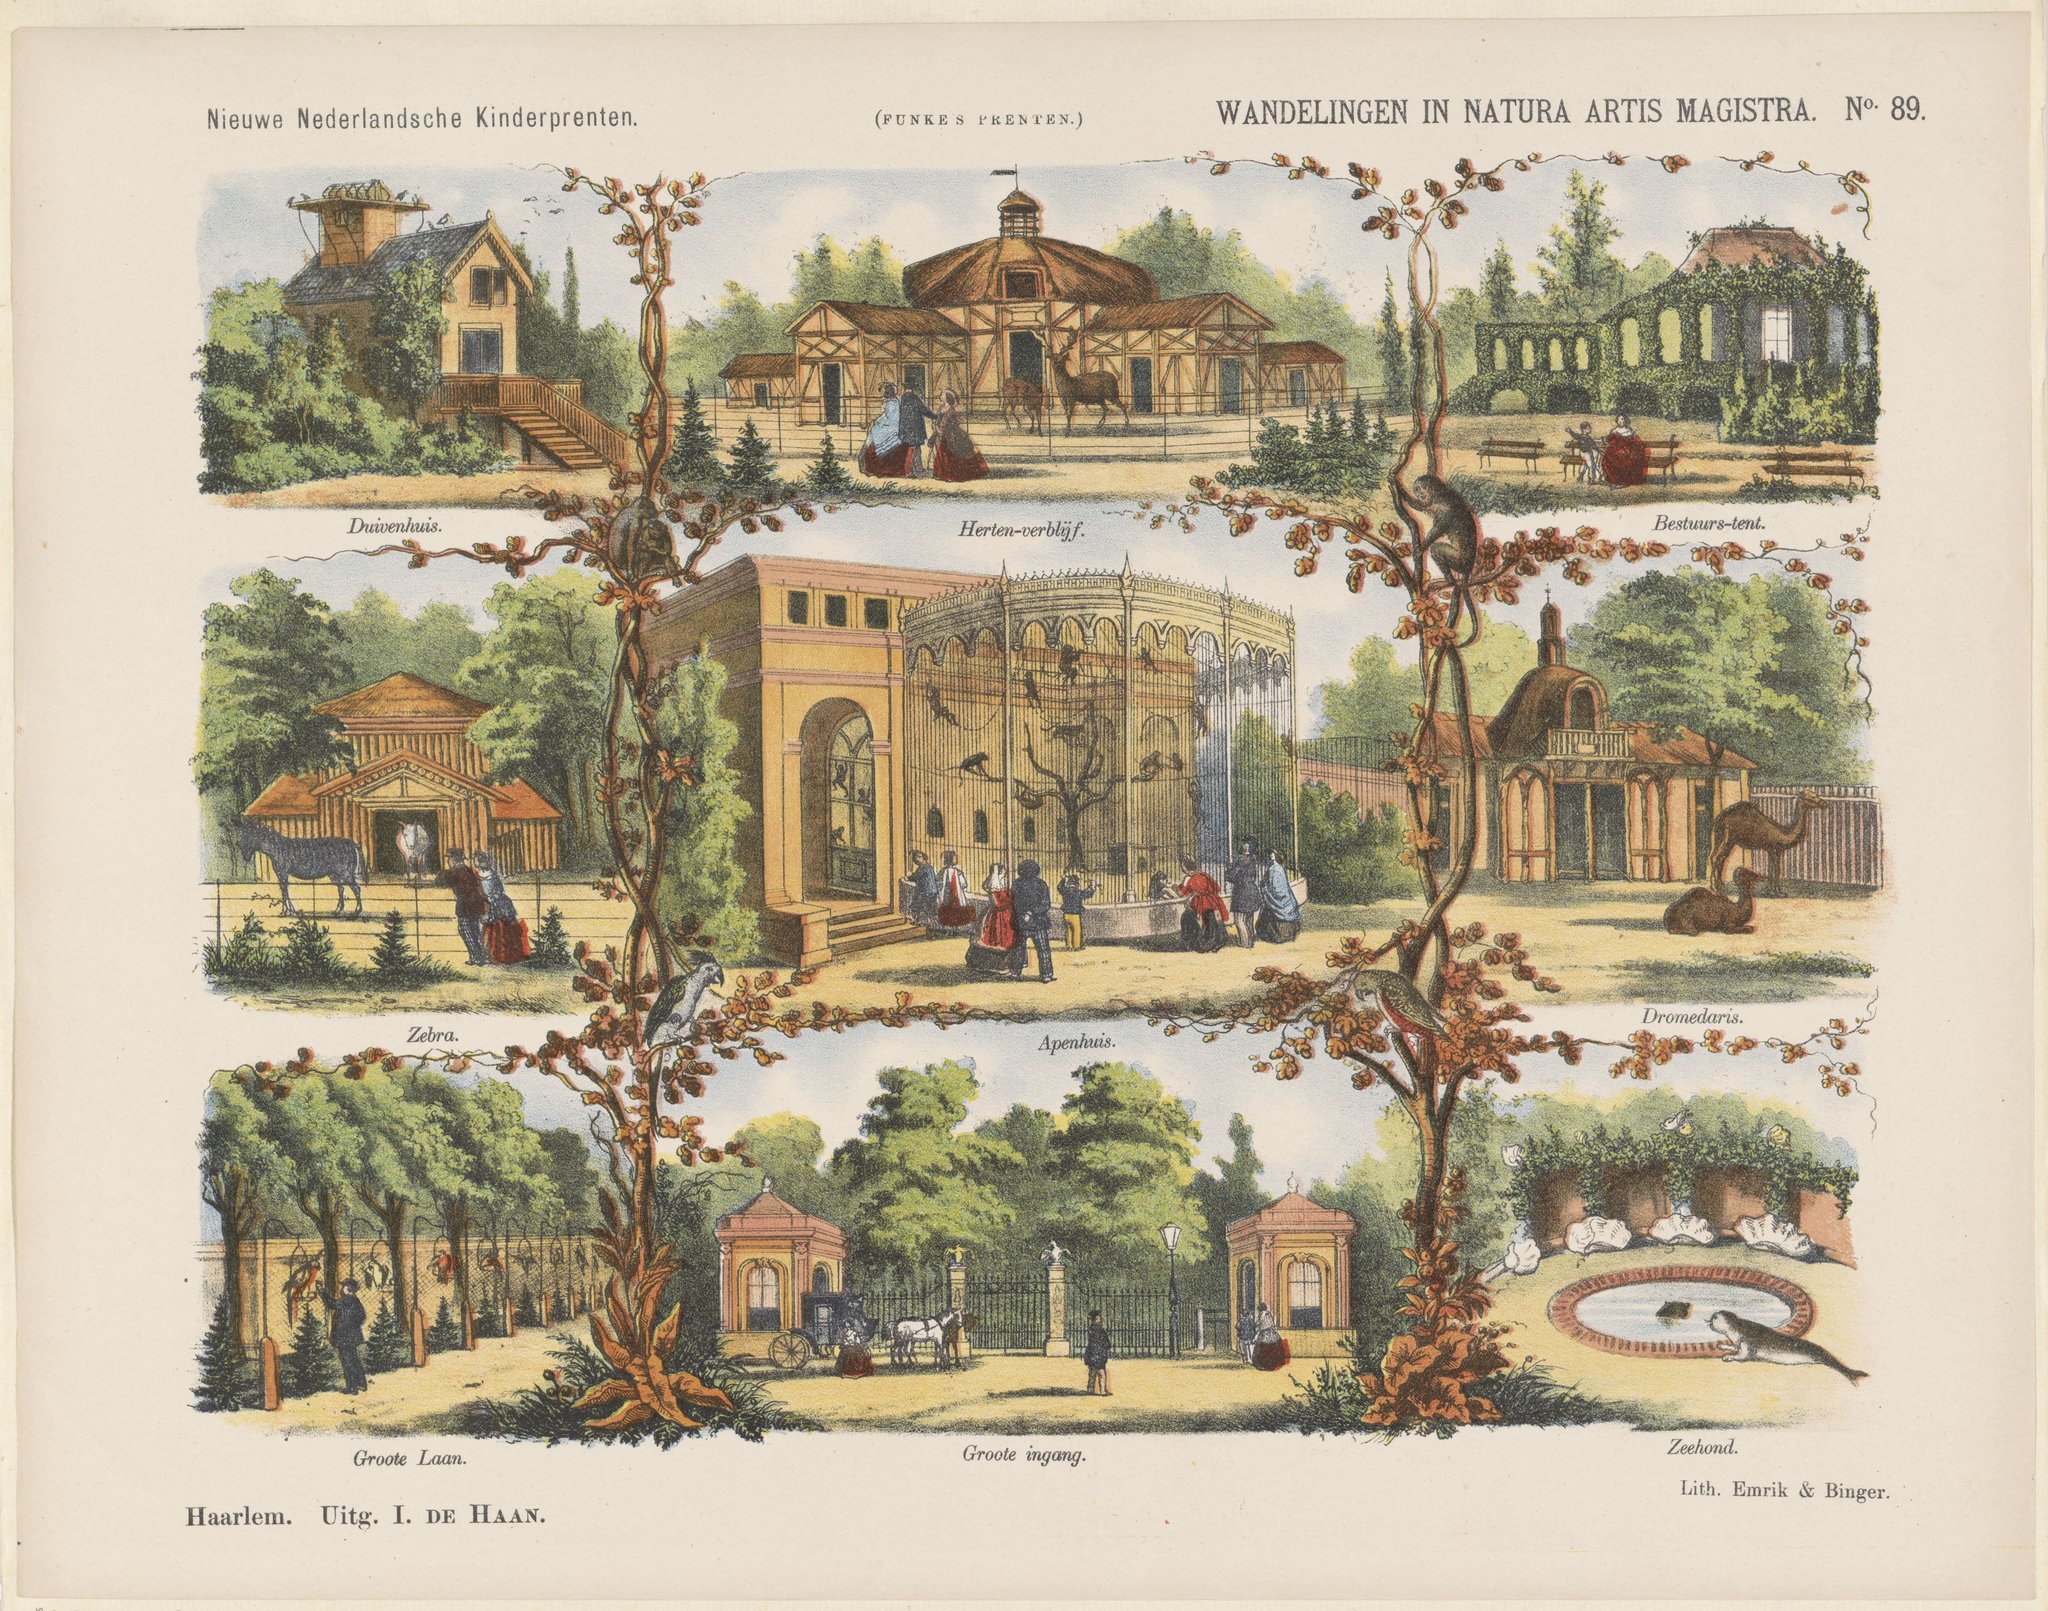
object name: popular print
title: Funke's prenten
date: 1875-1903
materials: paper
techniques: lithograph, letterpress printing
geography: haarlem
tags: zoological garden, zoo, seen as place where non-domestic animals are kept, zoo (as place of recreation)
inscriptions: collector's mark: Lugt 2760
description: Blad met 9 voorstellingen van gebouwen en dierenverblijven in de dierentuin Natura Artis Magistra, waaronder voorstellingen van het duivenhuis, het hertenverblijf en het apenhuis. Onder elke afbeelding een onderschrift. Genummerd rechtsboven: No. 89.